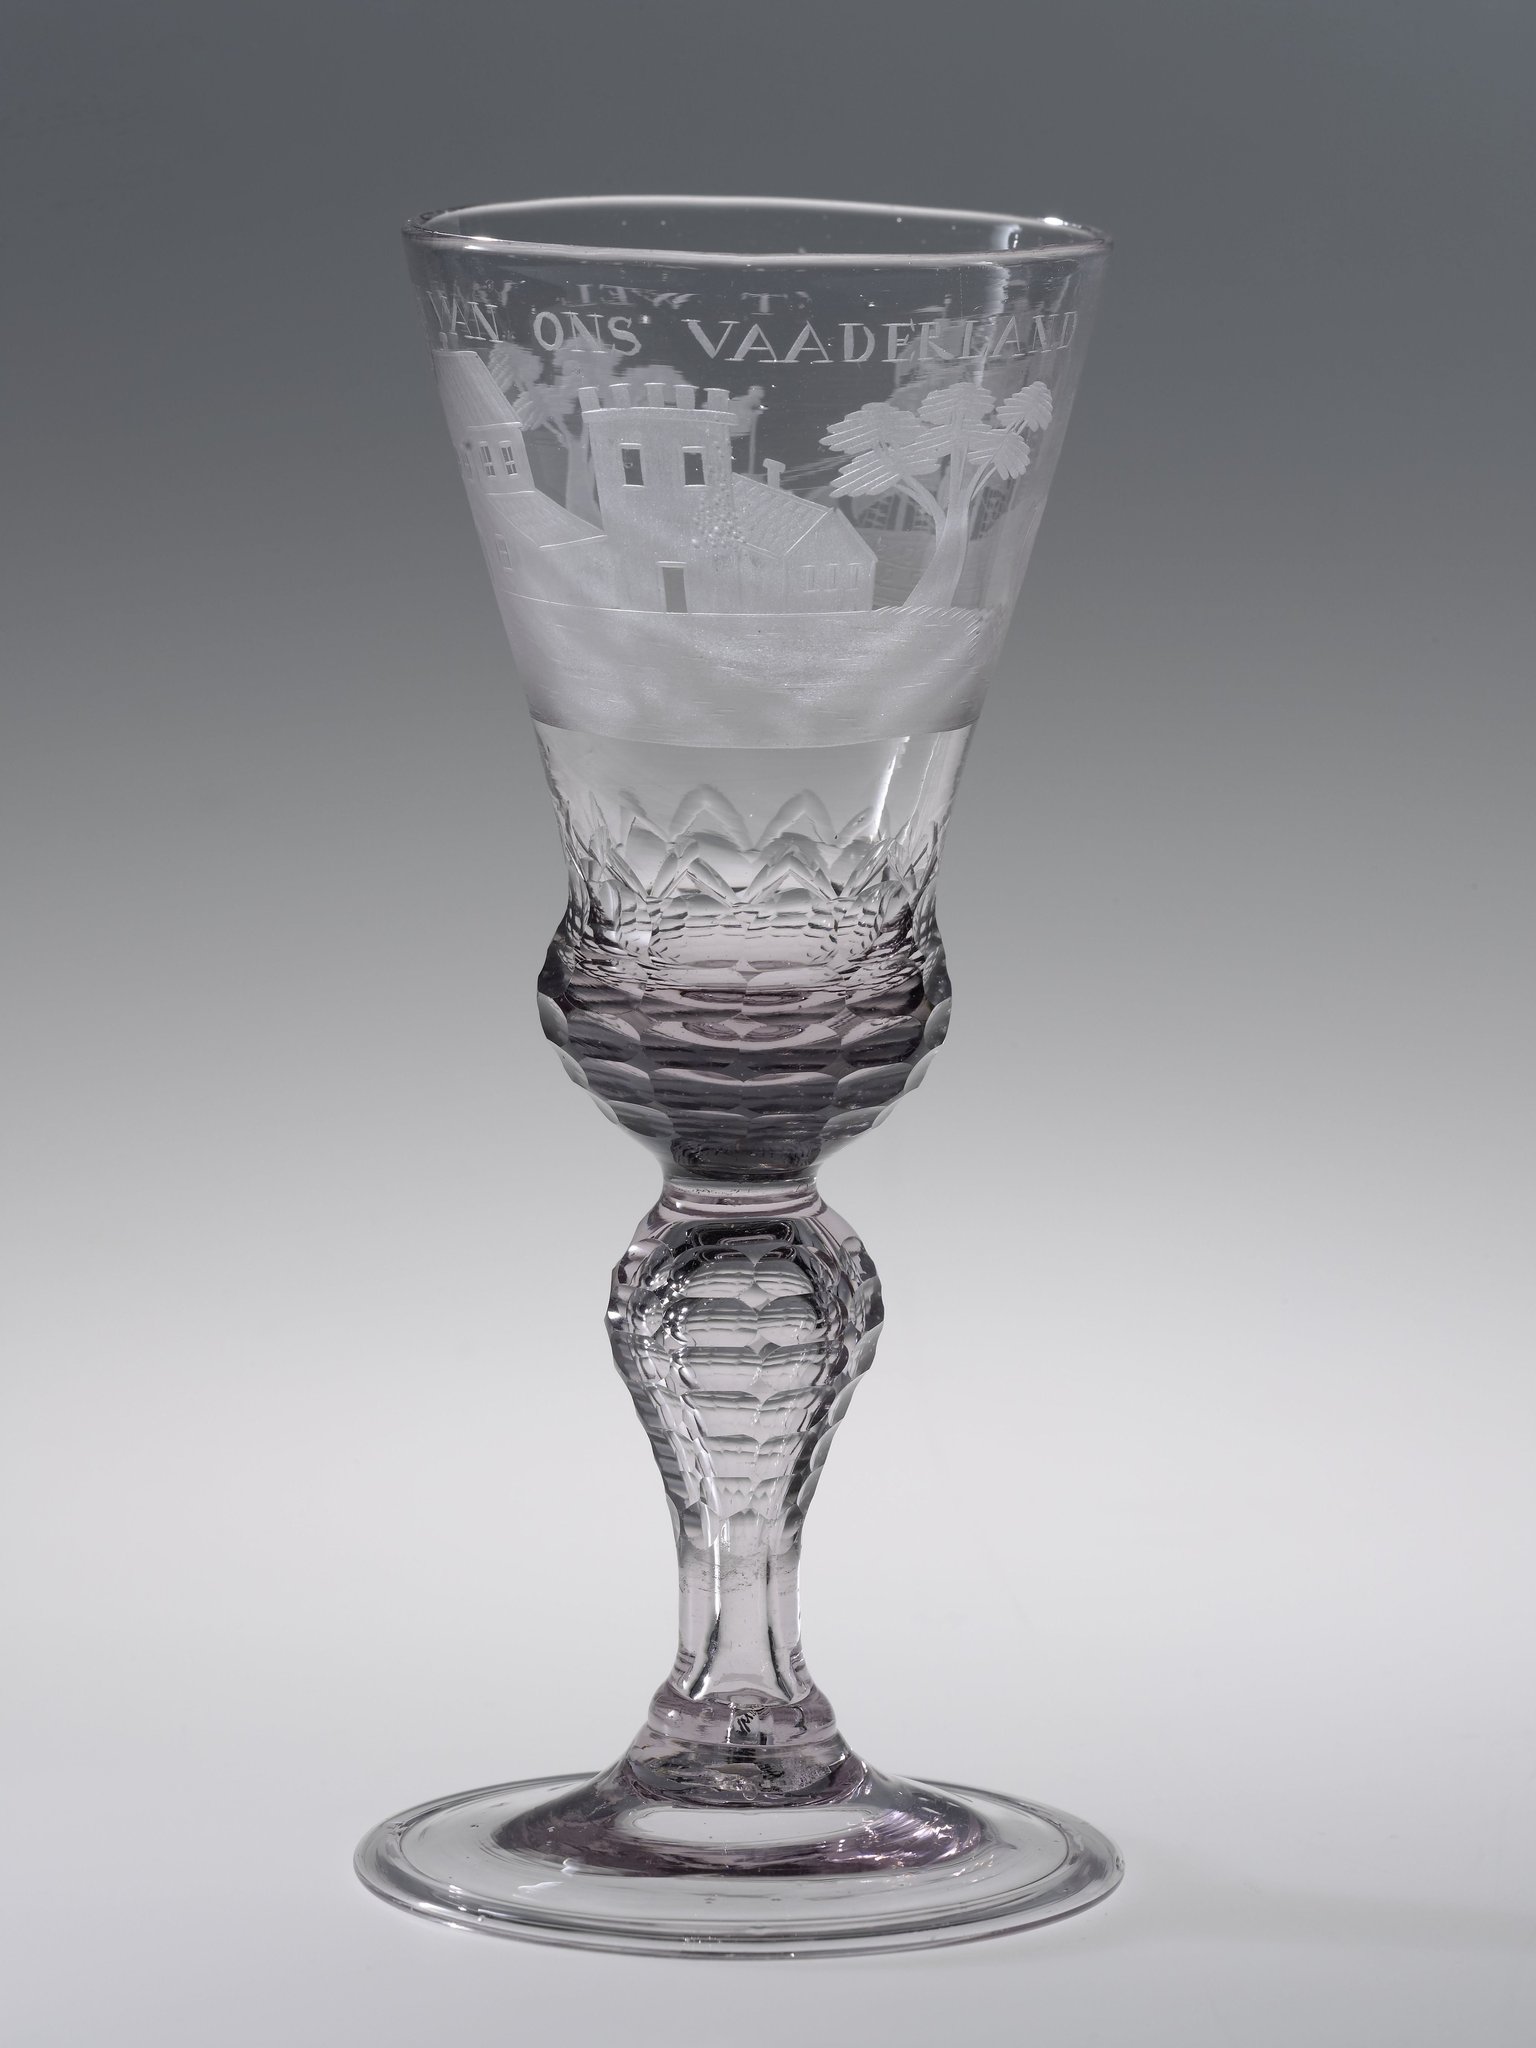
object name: goblet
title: Bokaal met een driemaster en het opschrift: 'T WEL.VAAREN VAN ONS VAADERLAND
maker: Anonymous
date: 1725-1750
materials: glass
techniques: glassblowing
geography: northern netherlands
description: Bokaal op gefacetteerde balusterstam. De kelk is van onderen verdikt en gefacetteerd. Op de kelk enige huizen en een koopvaarder waarboven: 'T WEL.VAAREN VAN ONS VAADERLAND.